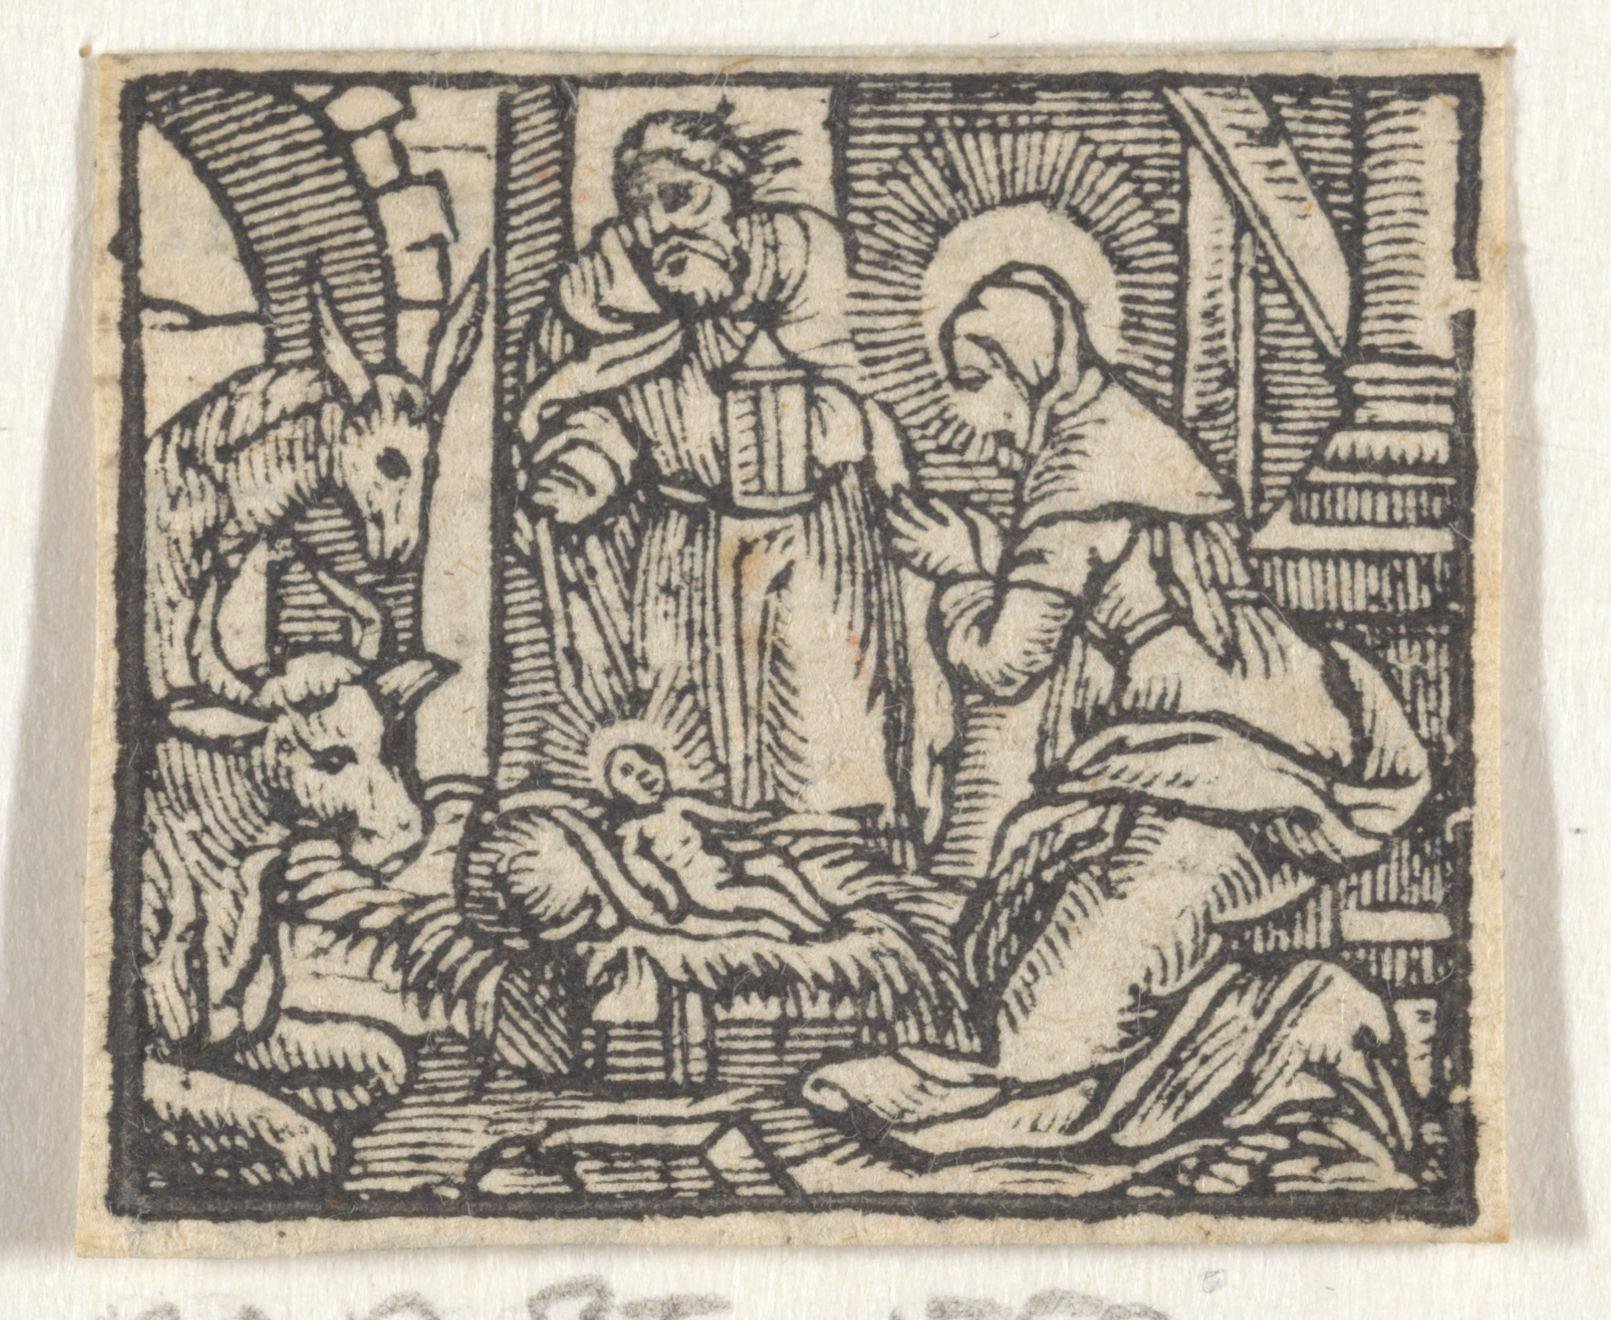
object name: print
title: Geboorte van Christus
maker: Anonymous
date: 1600-1699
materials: paper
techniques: letterpress printing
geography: netherlands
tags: mary, joseph and the new-born christ (nativity)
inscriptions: collector's mark: Lugt 240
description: Maria en Jozef in de stal met de os en de ezel naast de kribbe met het Christuskind.